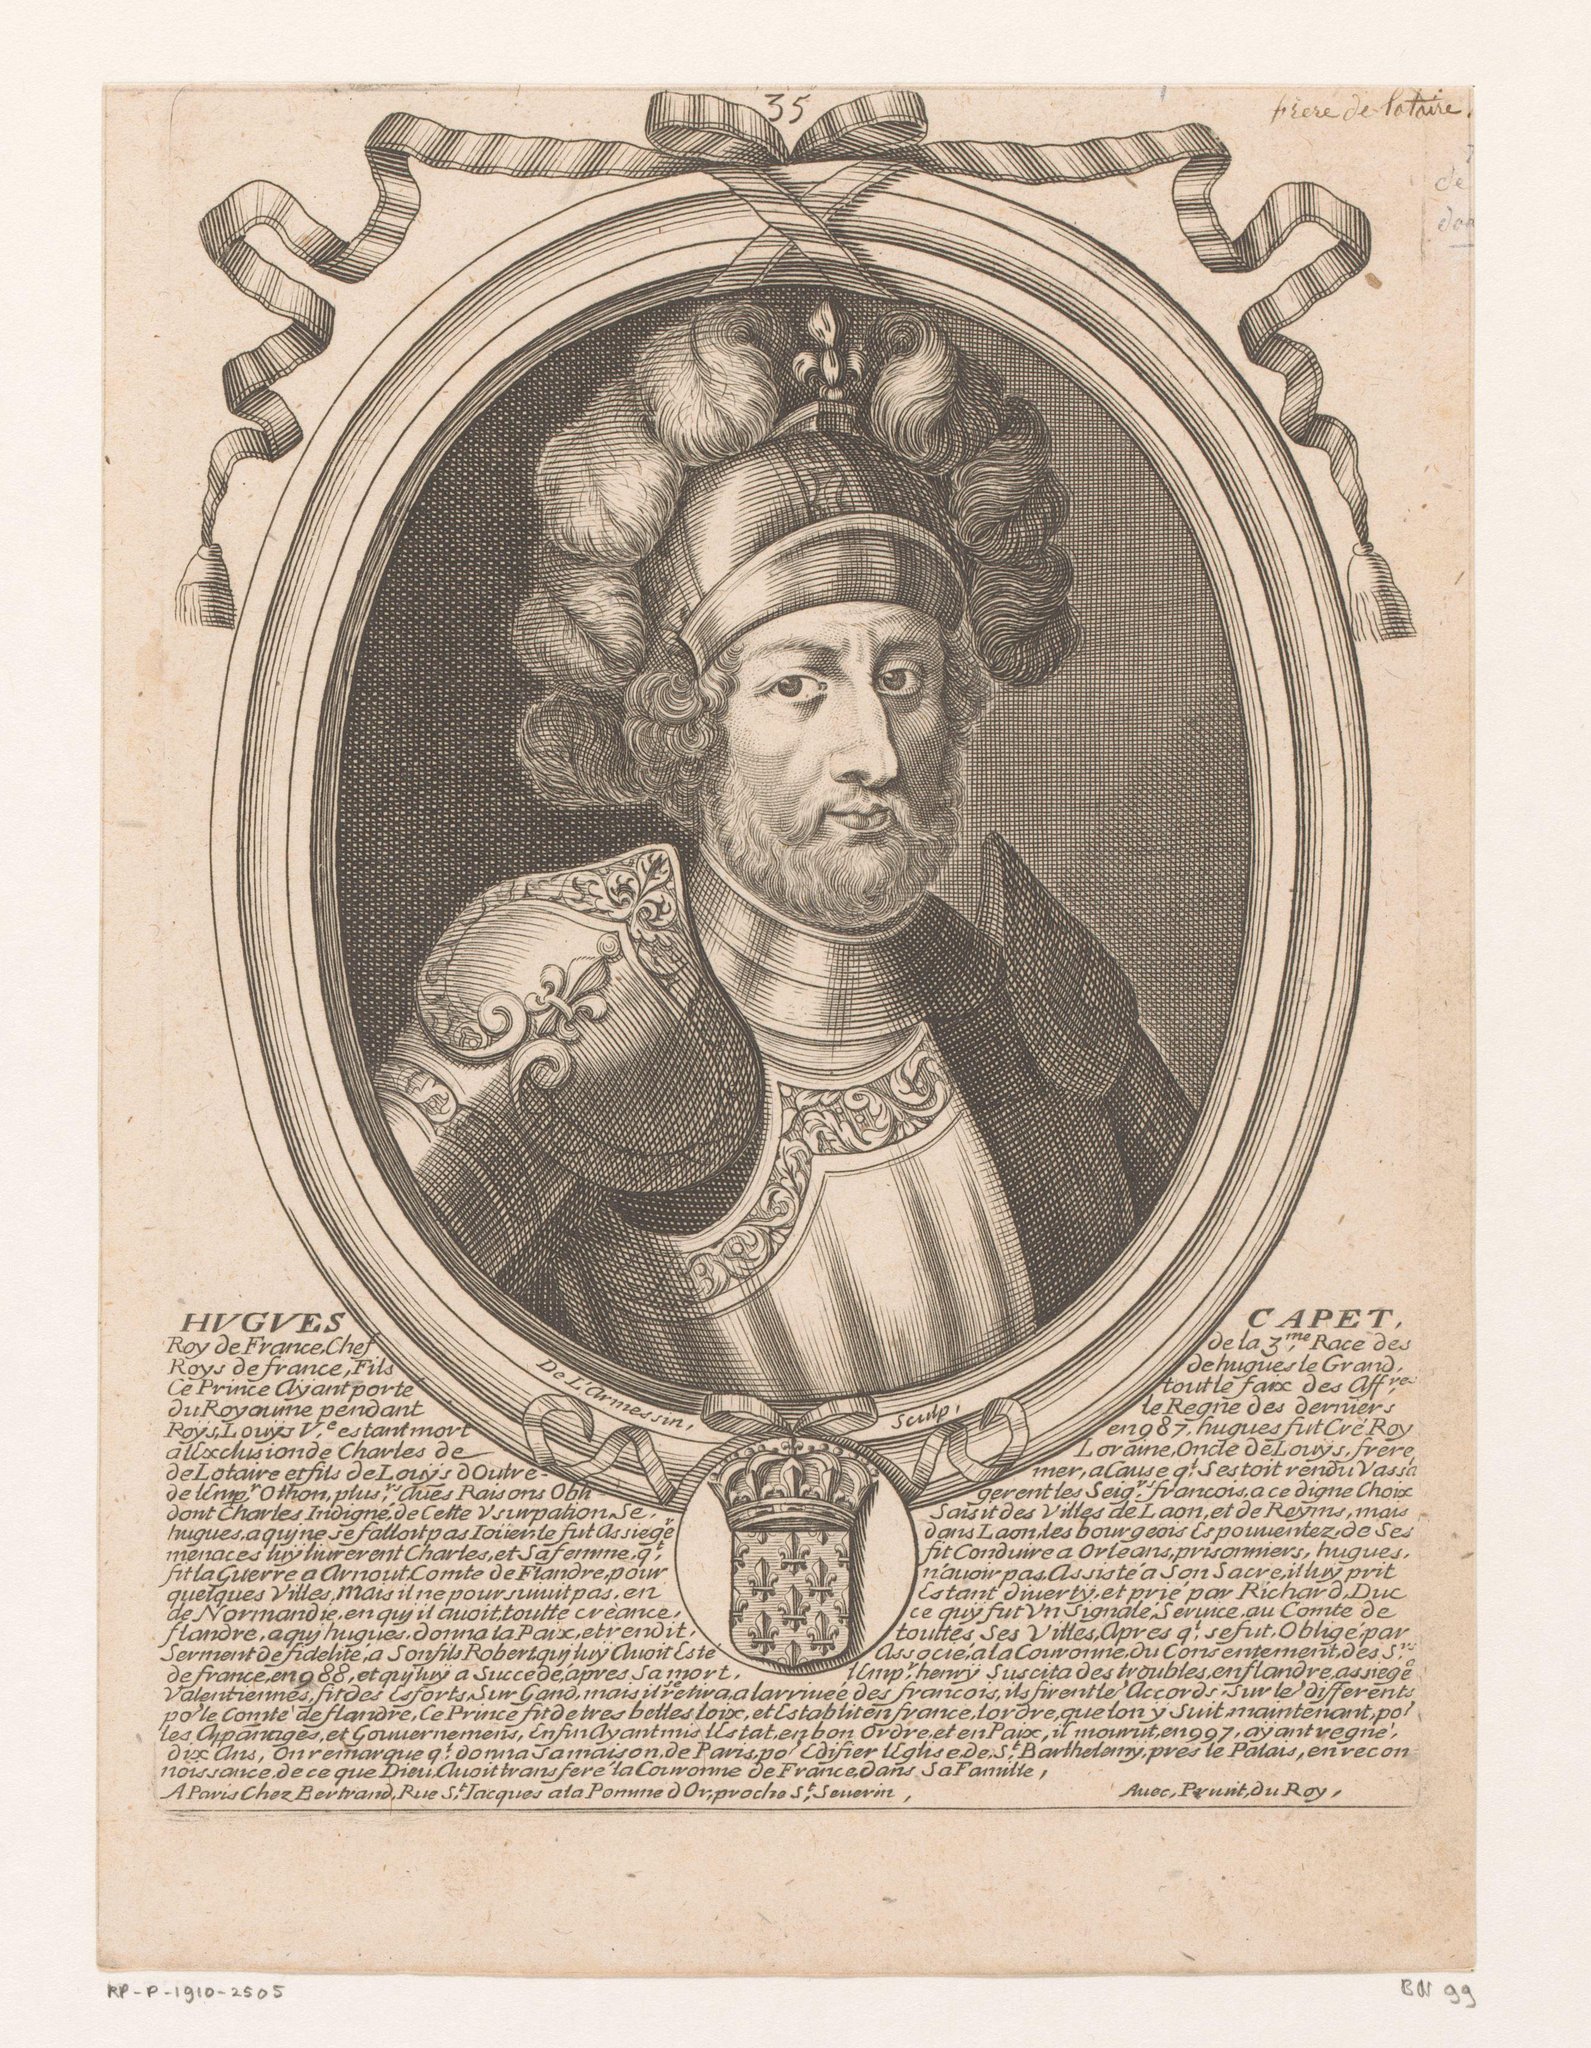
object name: print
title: Hugues Capet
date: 1642-1678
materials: paper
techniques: engraving, etching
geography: france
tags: historical persons, king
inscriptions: inscription: ‘frère de lotaire.’, collector's mark: Lugt 2228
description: Maakt deel uit van een grootschalige serie met portretten van prominente figuren. Binnen de serie bevindt zich een sectie getiteld 'Les Augustes Représentations De tous les Roys De France depuis Pharamond Iusqu'à Louys XIIII'. De serie werd respectievelijk uitgegeven door Pierre Bertrand, door zijn weduwe en door De Larmessin zelf.